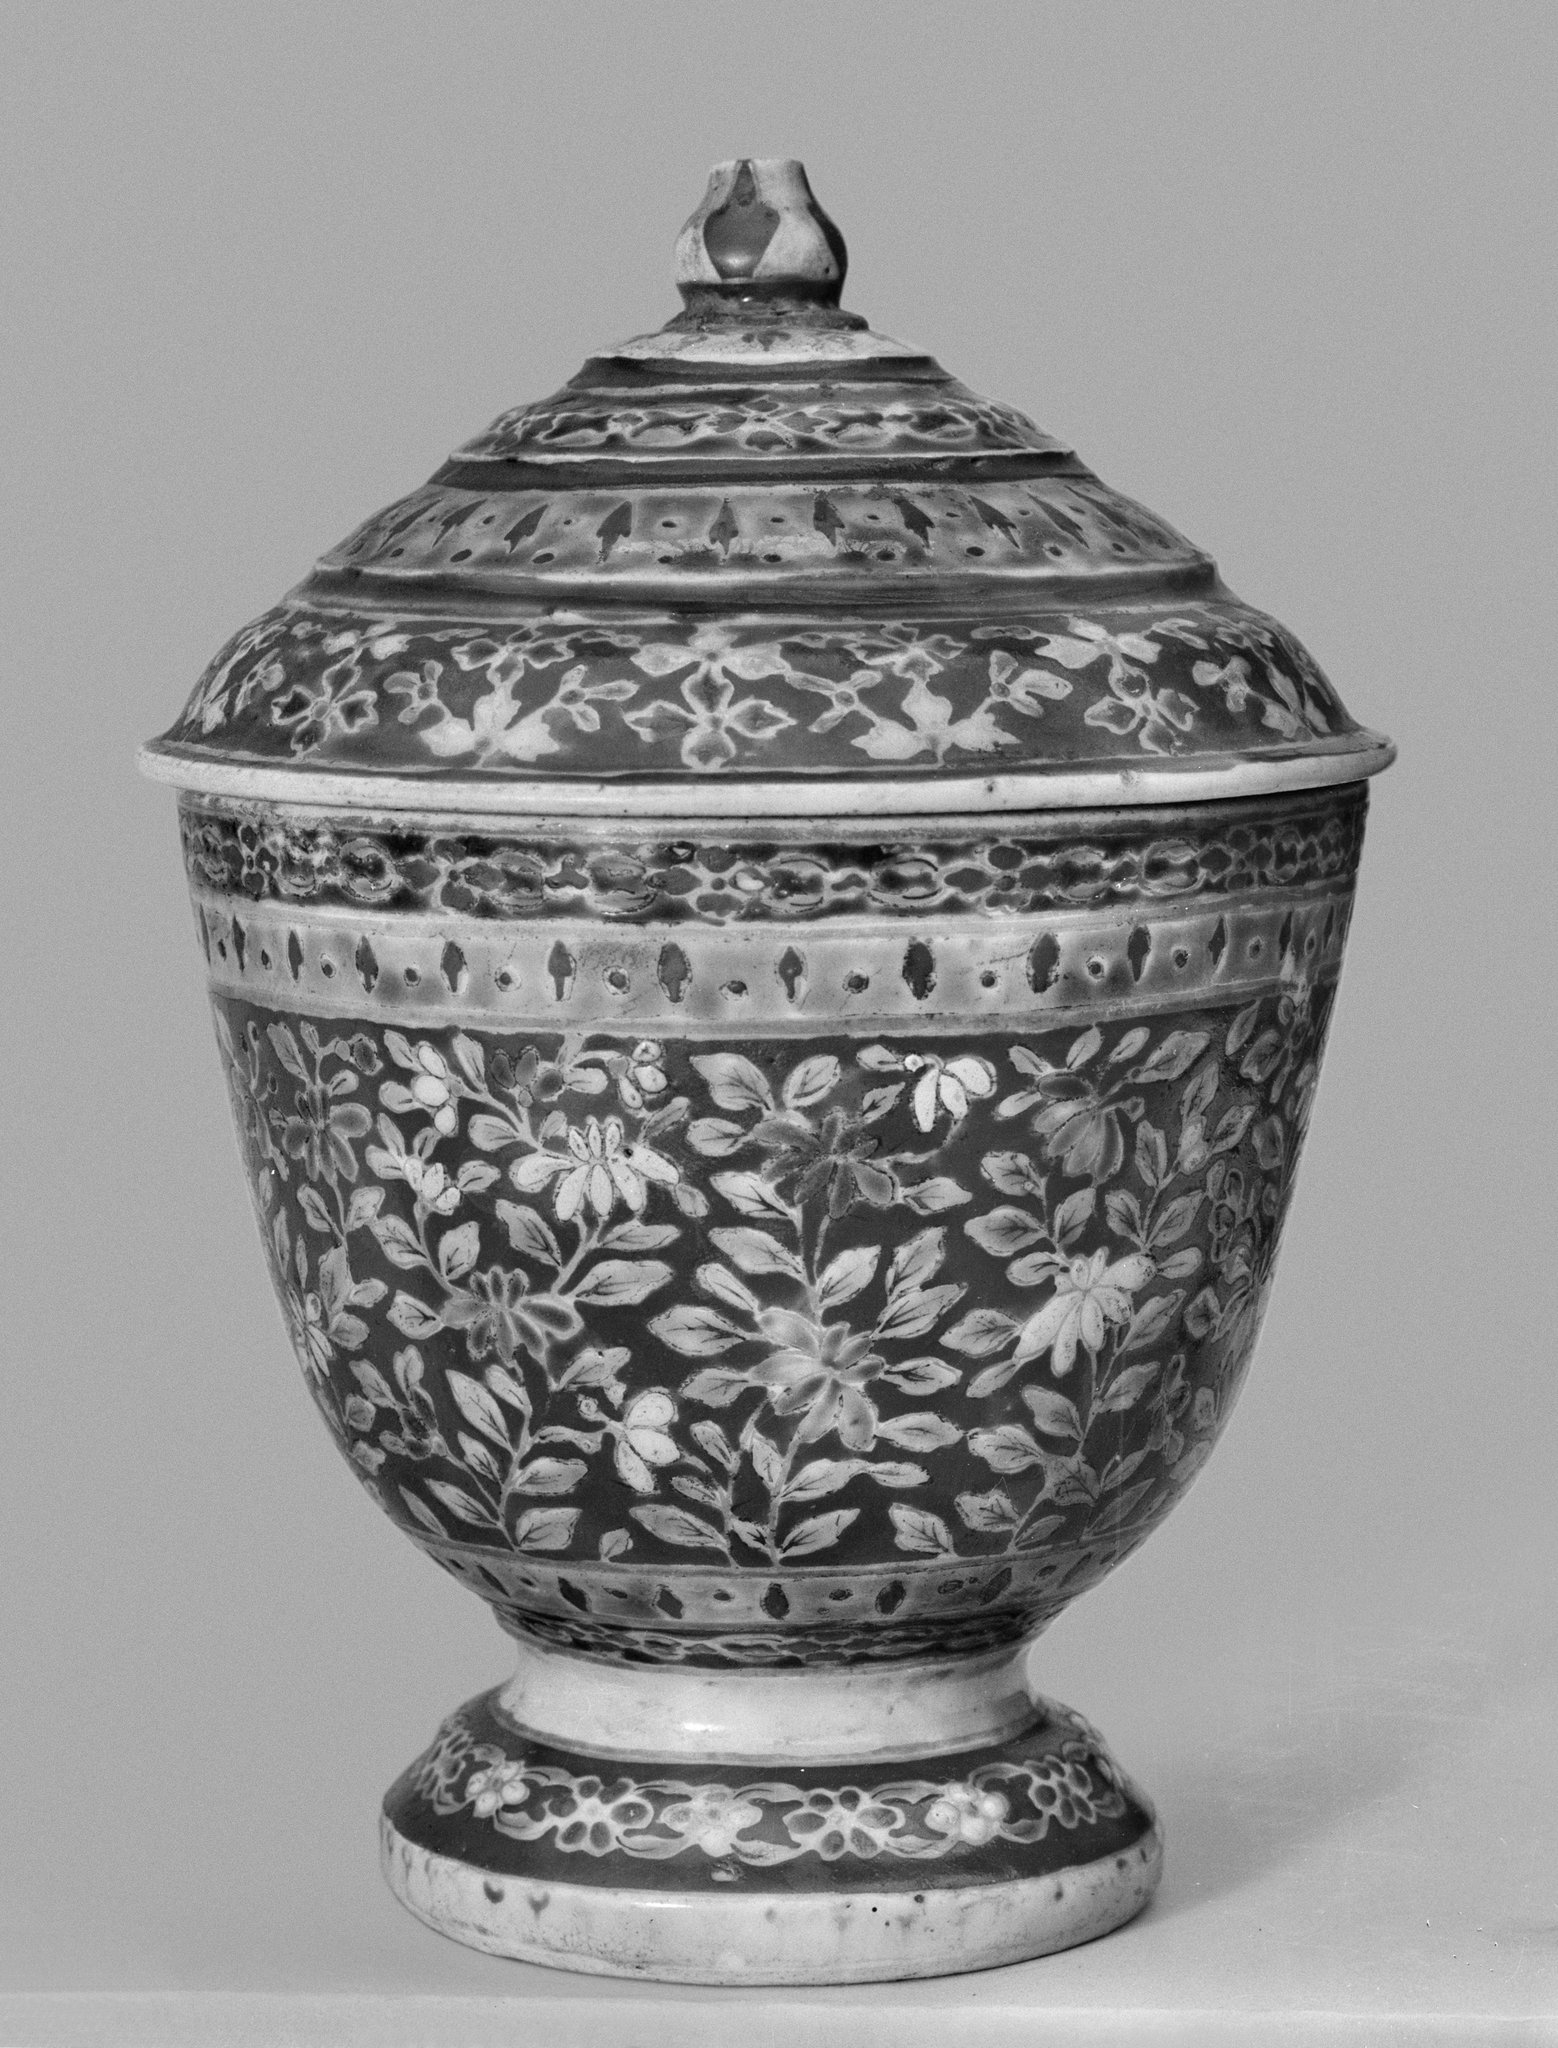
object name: covered bowl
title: Covered bowl with floral patterns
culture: chinese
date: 1801-1900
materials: enamel, porcelain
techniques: overglaze, painting, polychrome